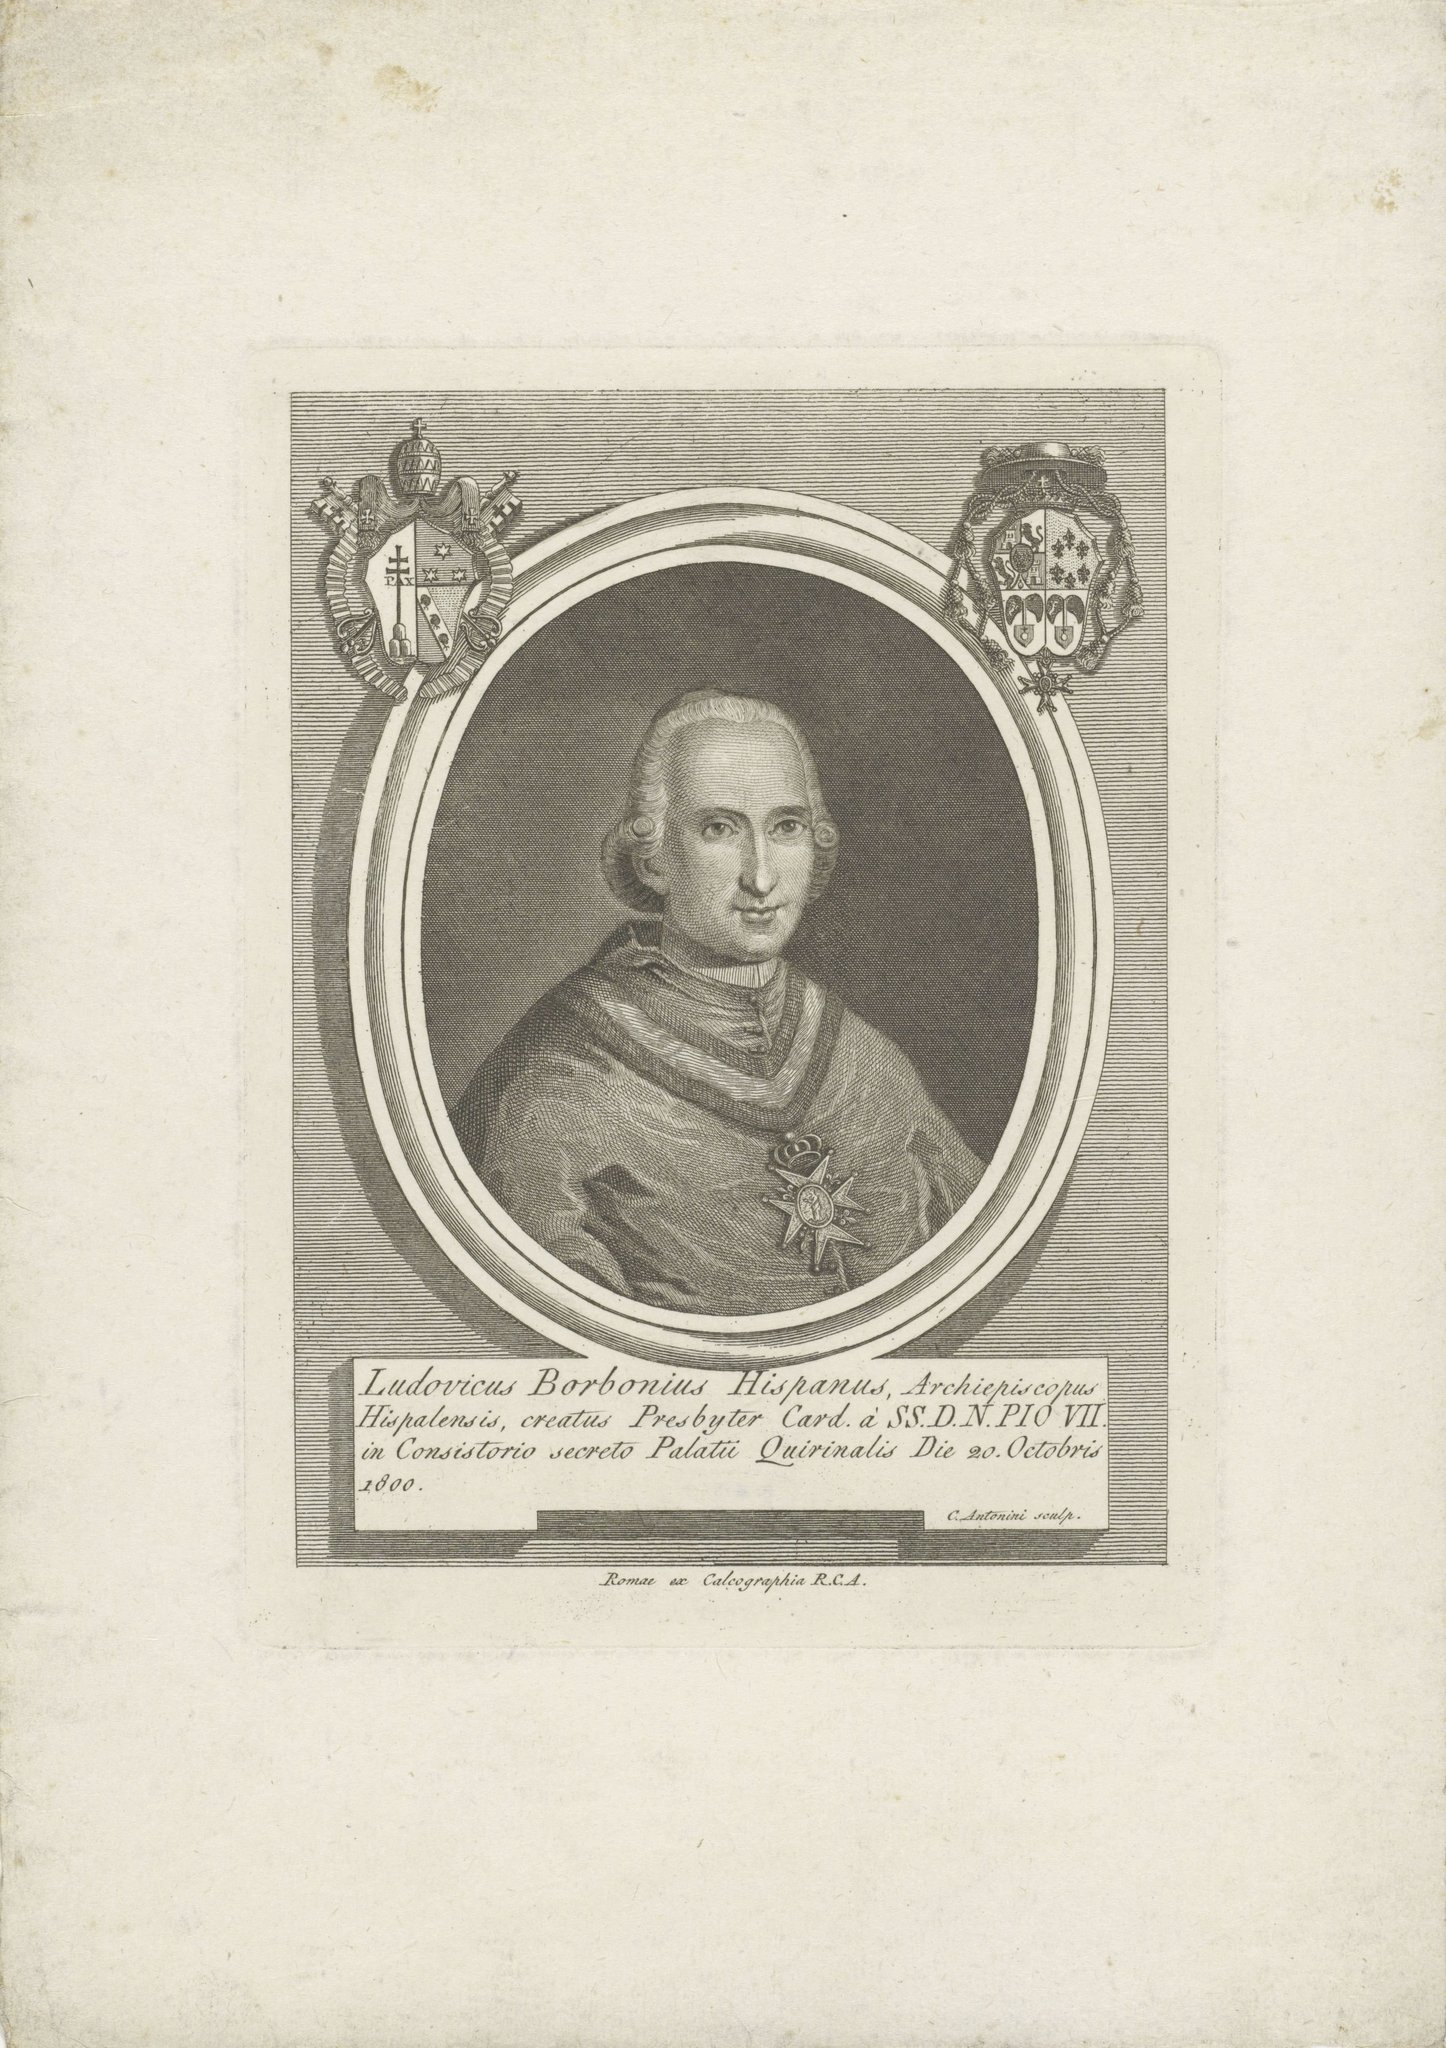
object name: print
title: Portret van Luis María de Borbón y Vallabriga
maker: carlo antonini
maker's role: print maker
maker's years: 1749-1835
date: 1800-1805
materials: paper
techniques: engraving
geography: italy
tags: historical persons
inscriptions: collector's mark: Lugt 2228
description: Portret van Kardinaal Luis María de Borbón y Vallabriga in een ovaal. Boven twee wapenschilden. Onder het portret een kader met tekst in het Latijn.